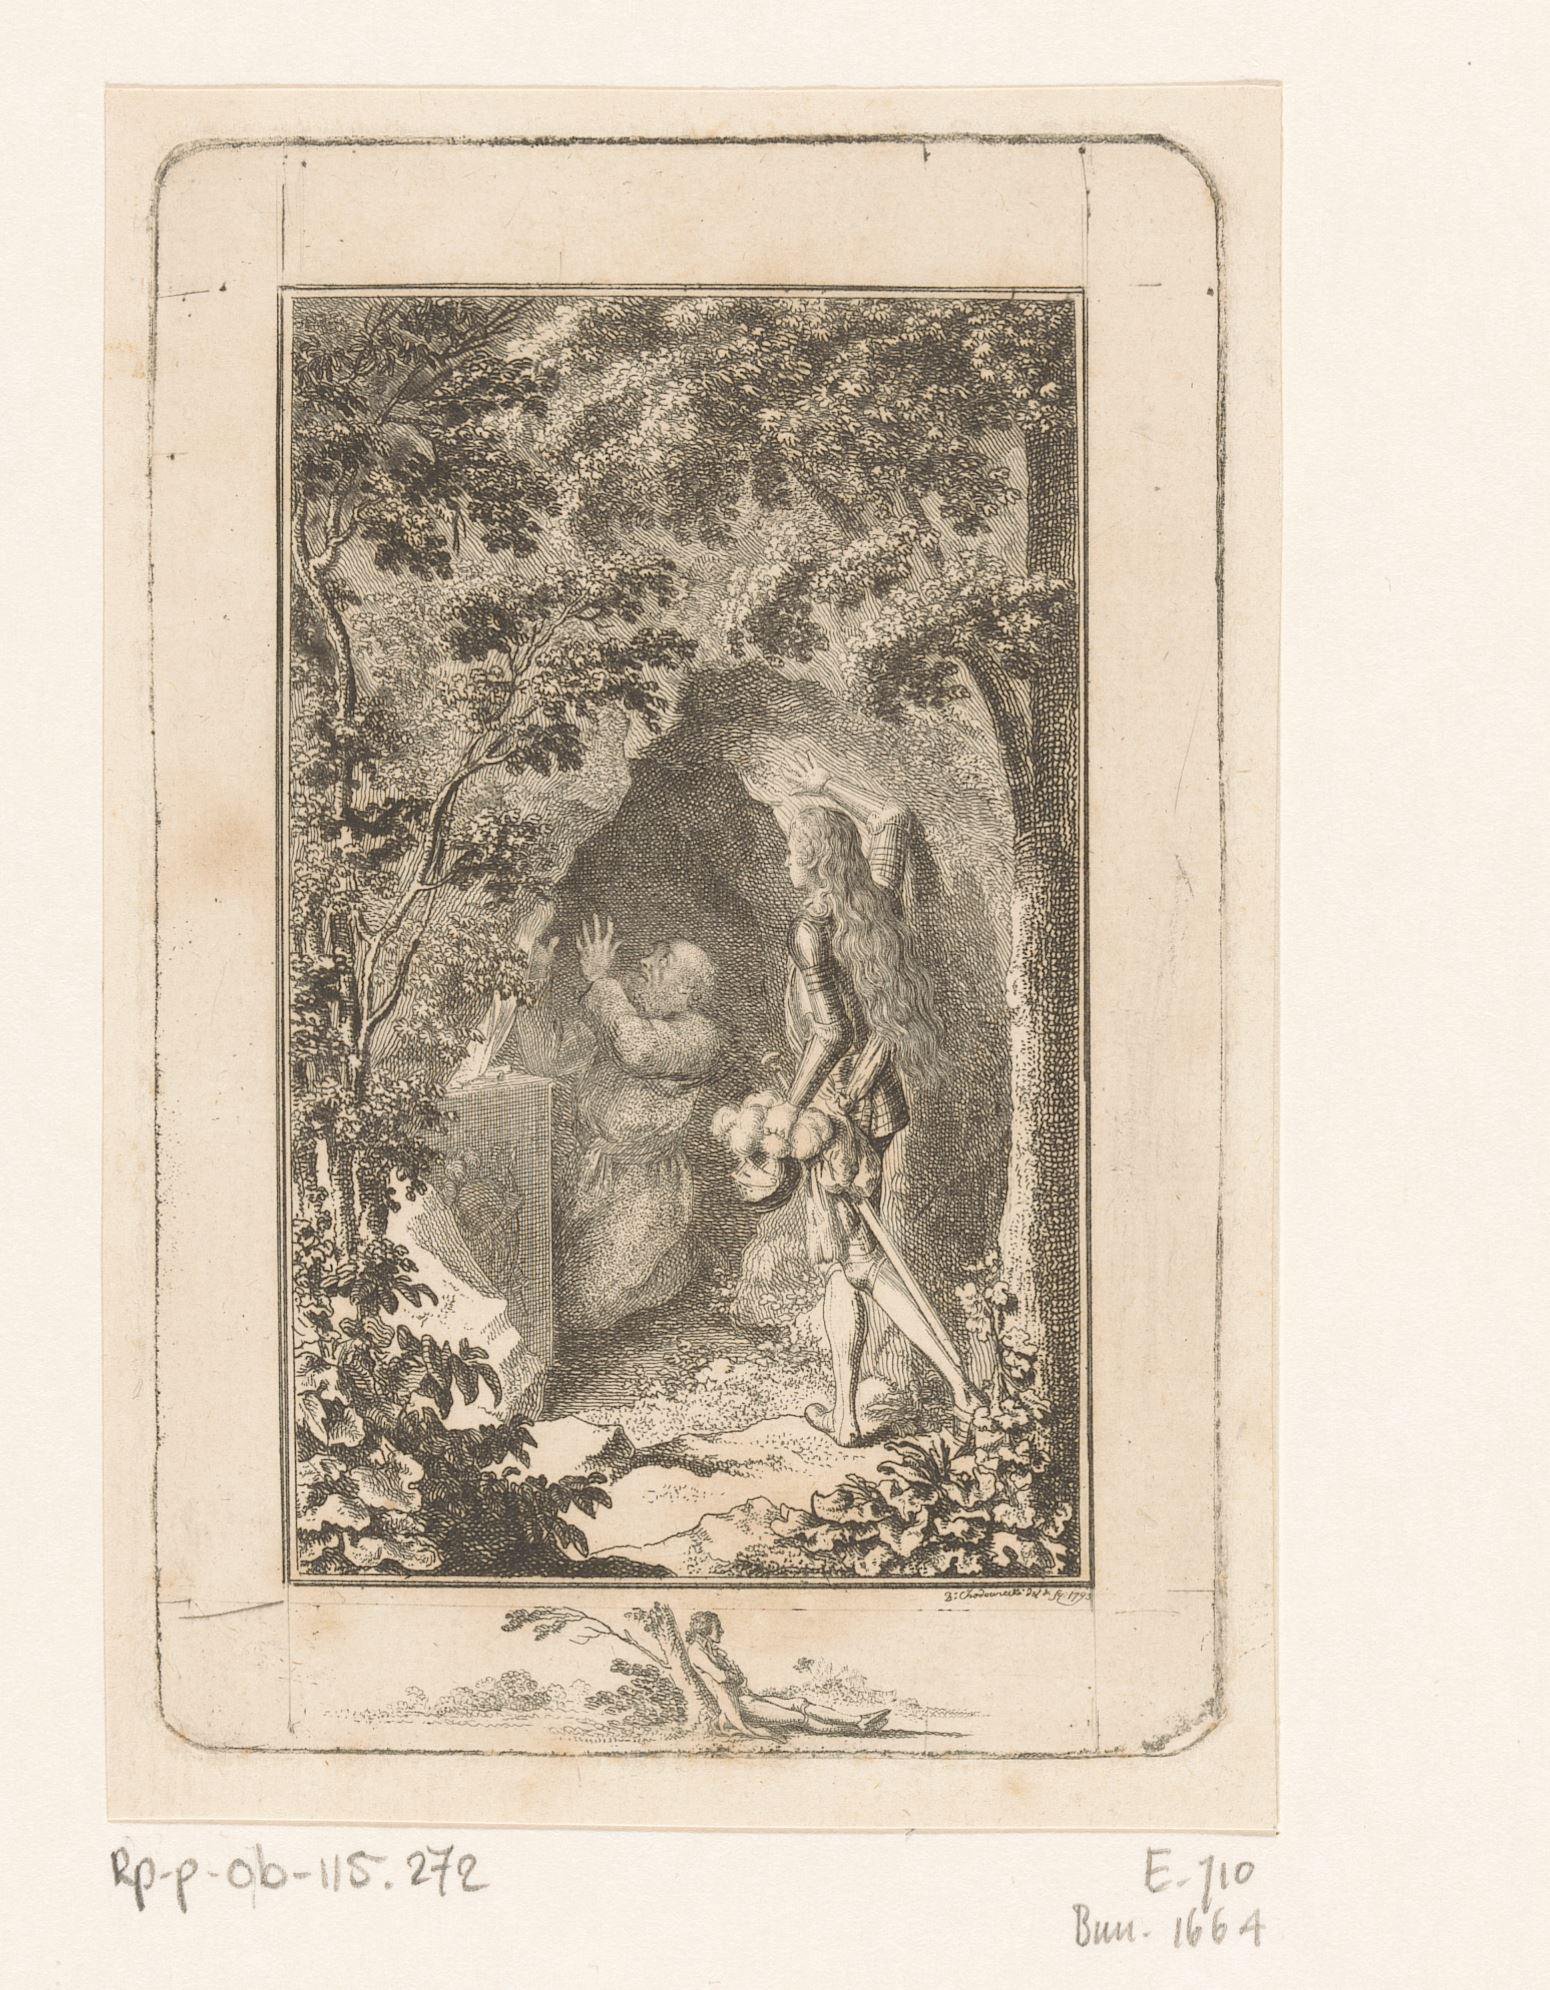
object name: print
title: Rolf ontdekt Suavilde, die in een grot tot Thor en Balder bidt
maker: daniel nikolaus chodowiecki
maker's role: draughtsman, print maker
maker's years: 1726-1801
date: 1793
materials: paper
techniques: etching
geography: berlin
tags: armour, cave, grotto, classical mythology and ancient history, altar, one person praying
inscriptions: collector's mark: Lugt 2228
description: Latere staat gebruikt voor: Mühlenpfordt, Georg. Scenen aus der Geschichte der alten nordischen Völker. Kopenhagen: Christian Gottlob Prost, 1793.